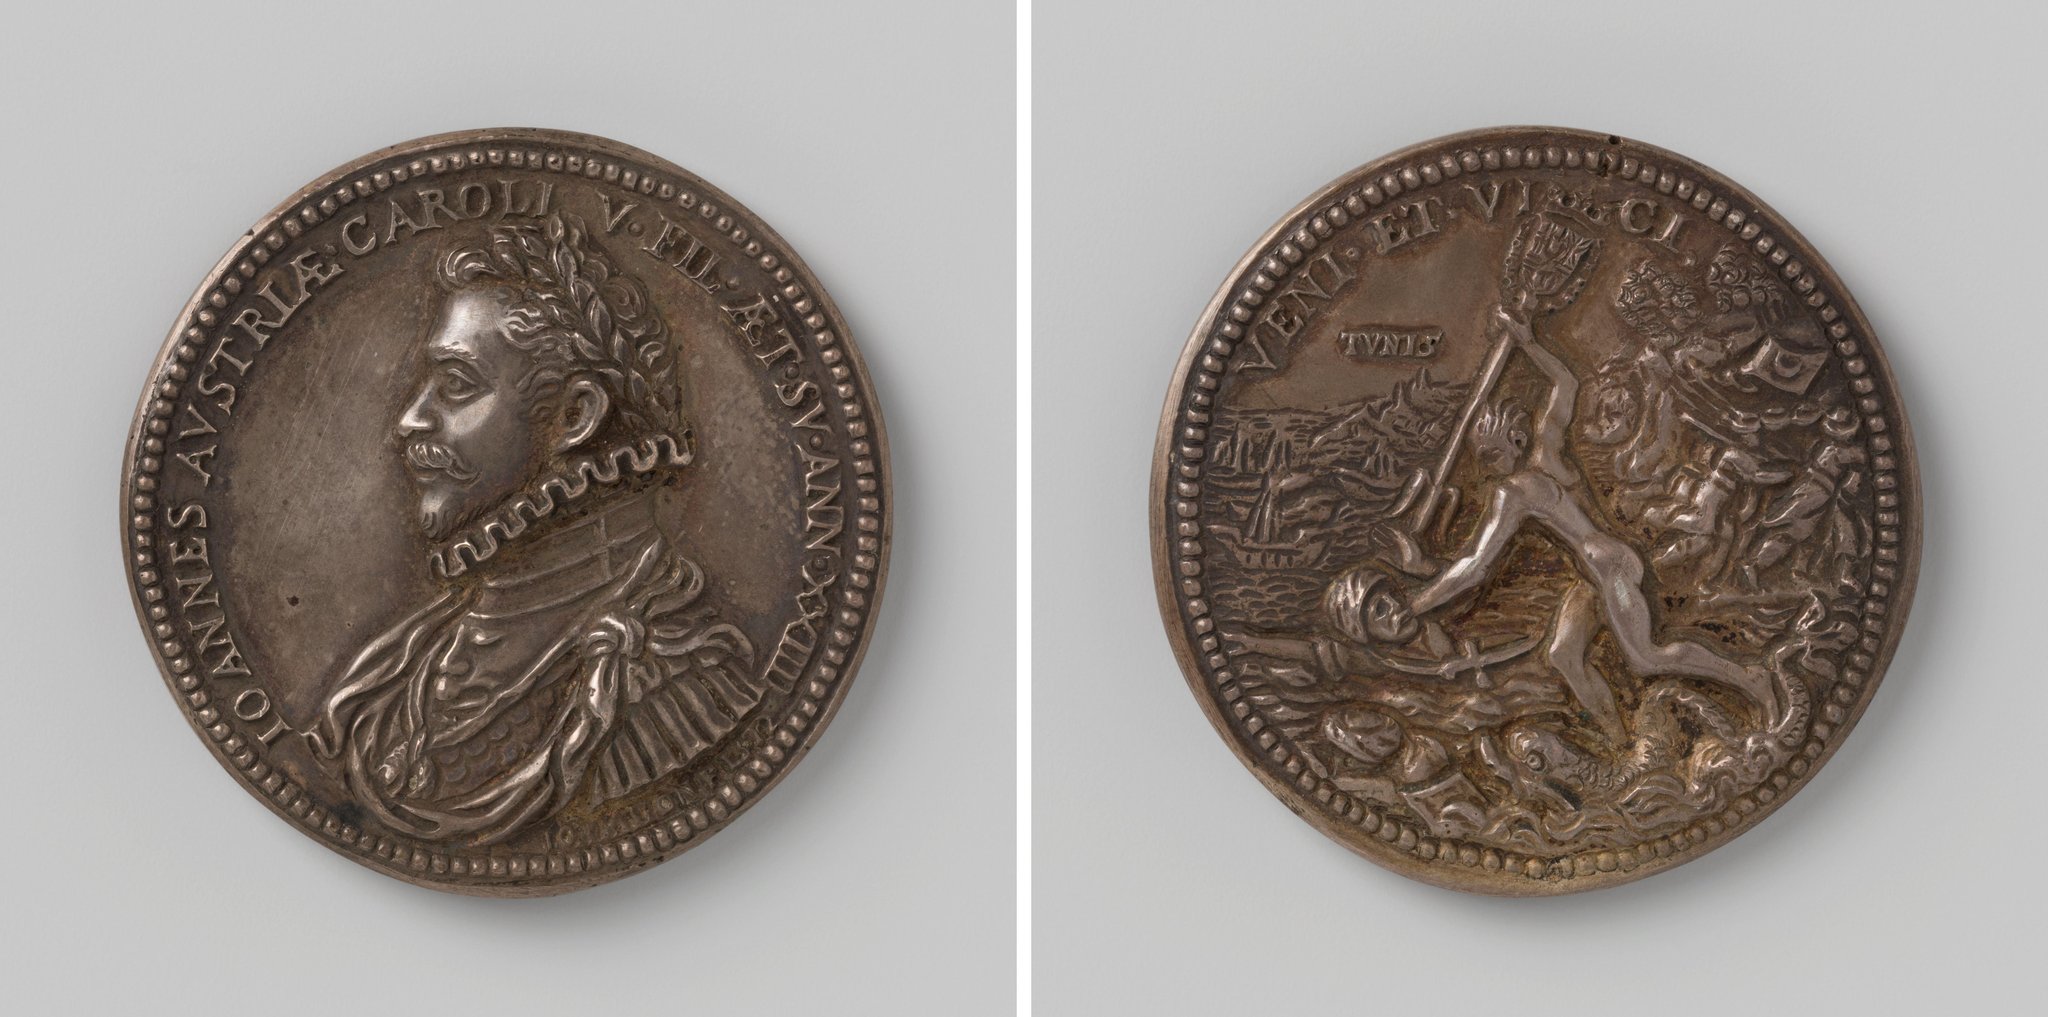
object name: history medal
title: Inname van Tunis door don Juan van Oostenrijk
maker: giovanni v. melon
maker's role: medailleur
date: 1572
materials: silver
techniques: casting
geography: rome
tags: don juan van oostenrijk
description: Zilveren penning. Voorzijde: borststuk man binnen omschrift. Keerzijde: Neptunus valt met zijn drietand, die aan bovenzijde uitloopt in een gekroond wapenschild een overboord geslagen Turk aan; op achtergrond gezicht op stad Tunis en vluchtende Turkse soldaten binnen omschrift.